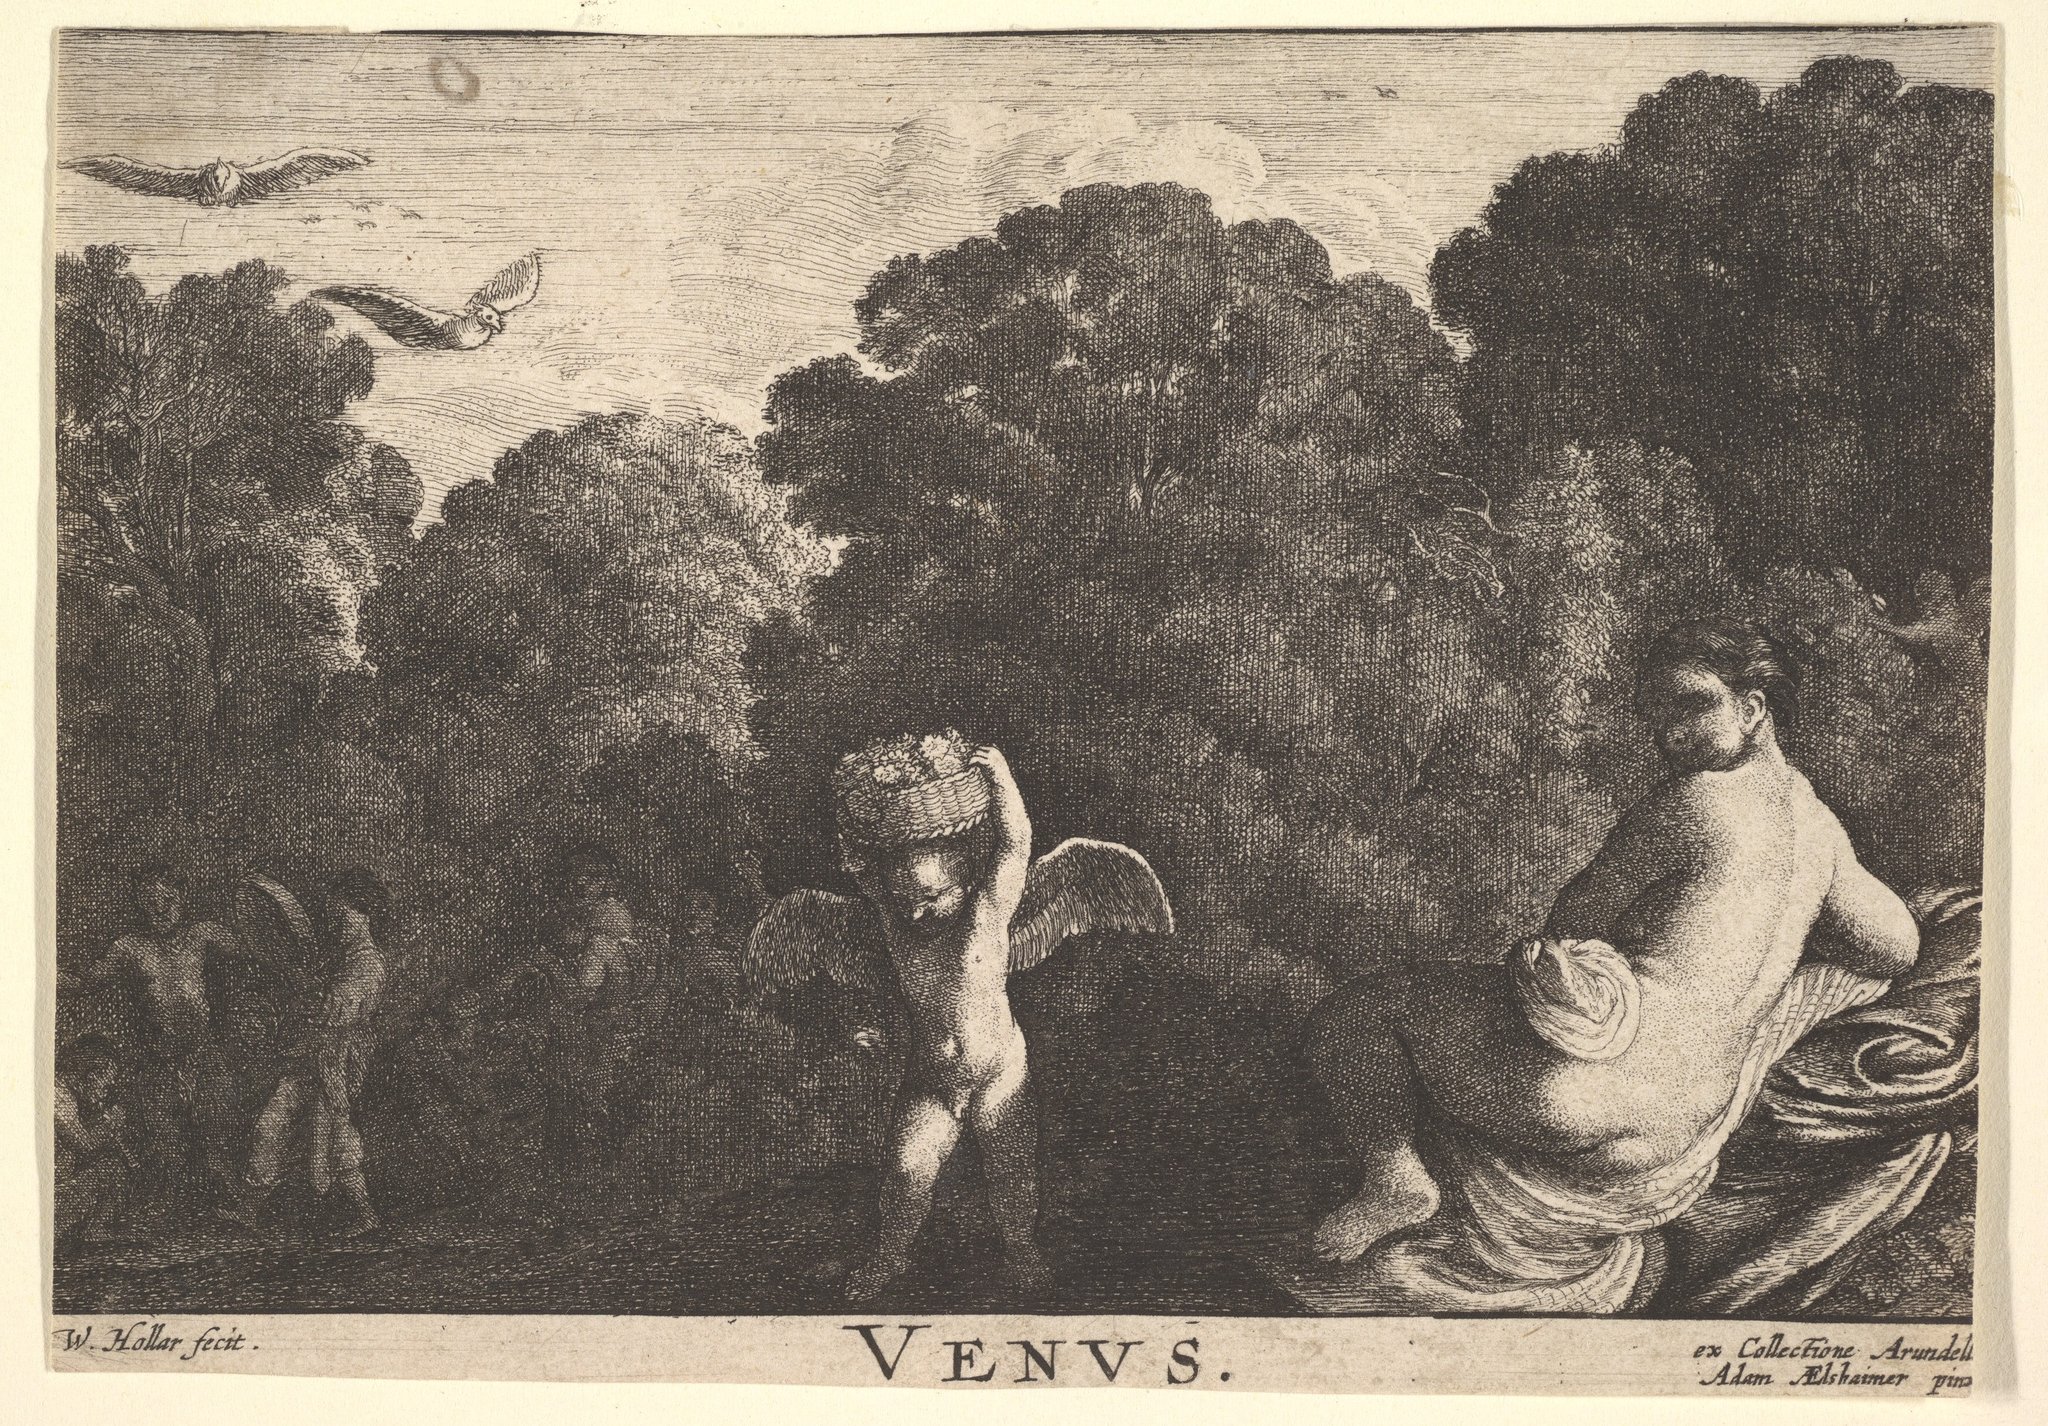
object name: print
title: Realm of Venus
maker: wenceslaus hollar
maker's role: artist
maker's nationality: bohemian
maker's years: 1607-1677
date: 1646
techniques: etching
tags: female nudes,cupid,venus